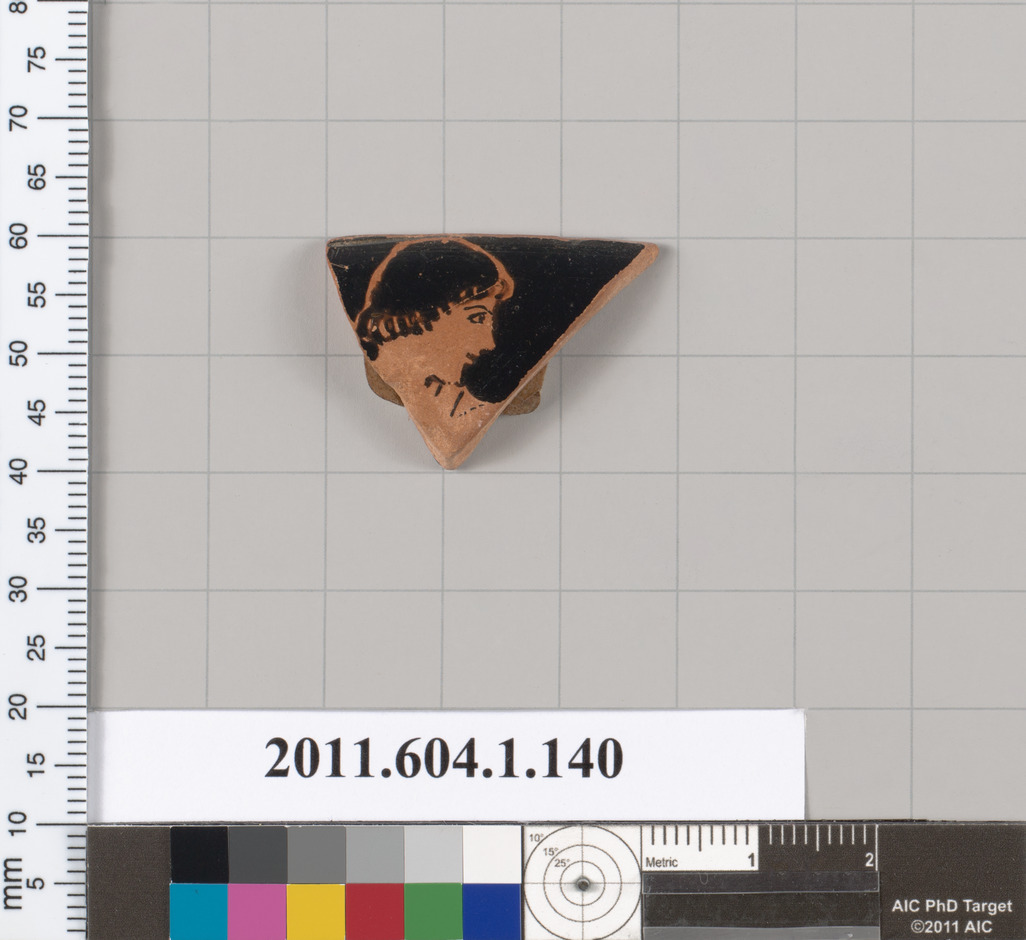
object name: kylix fragment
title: Terracotta rim fragment of a kylix (drinking cup)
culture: greek, attic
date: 475-451 BCE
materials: terracotta